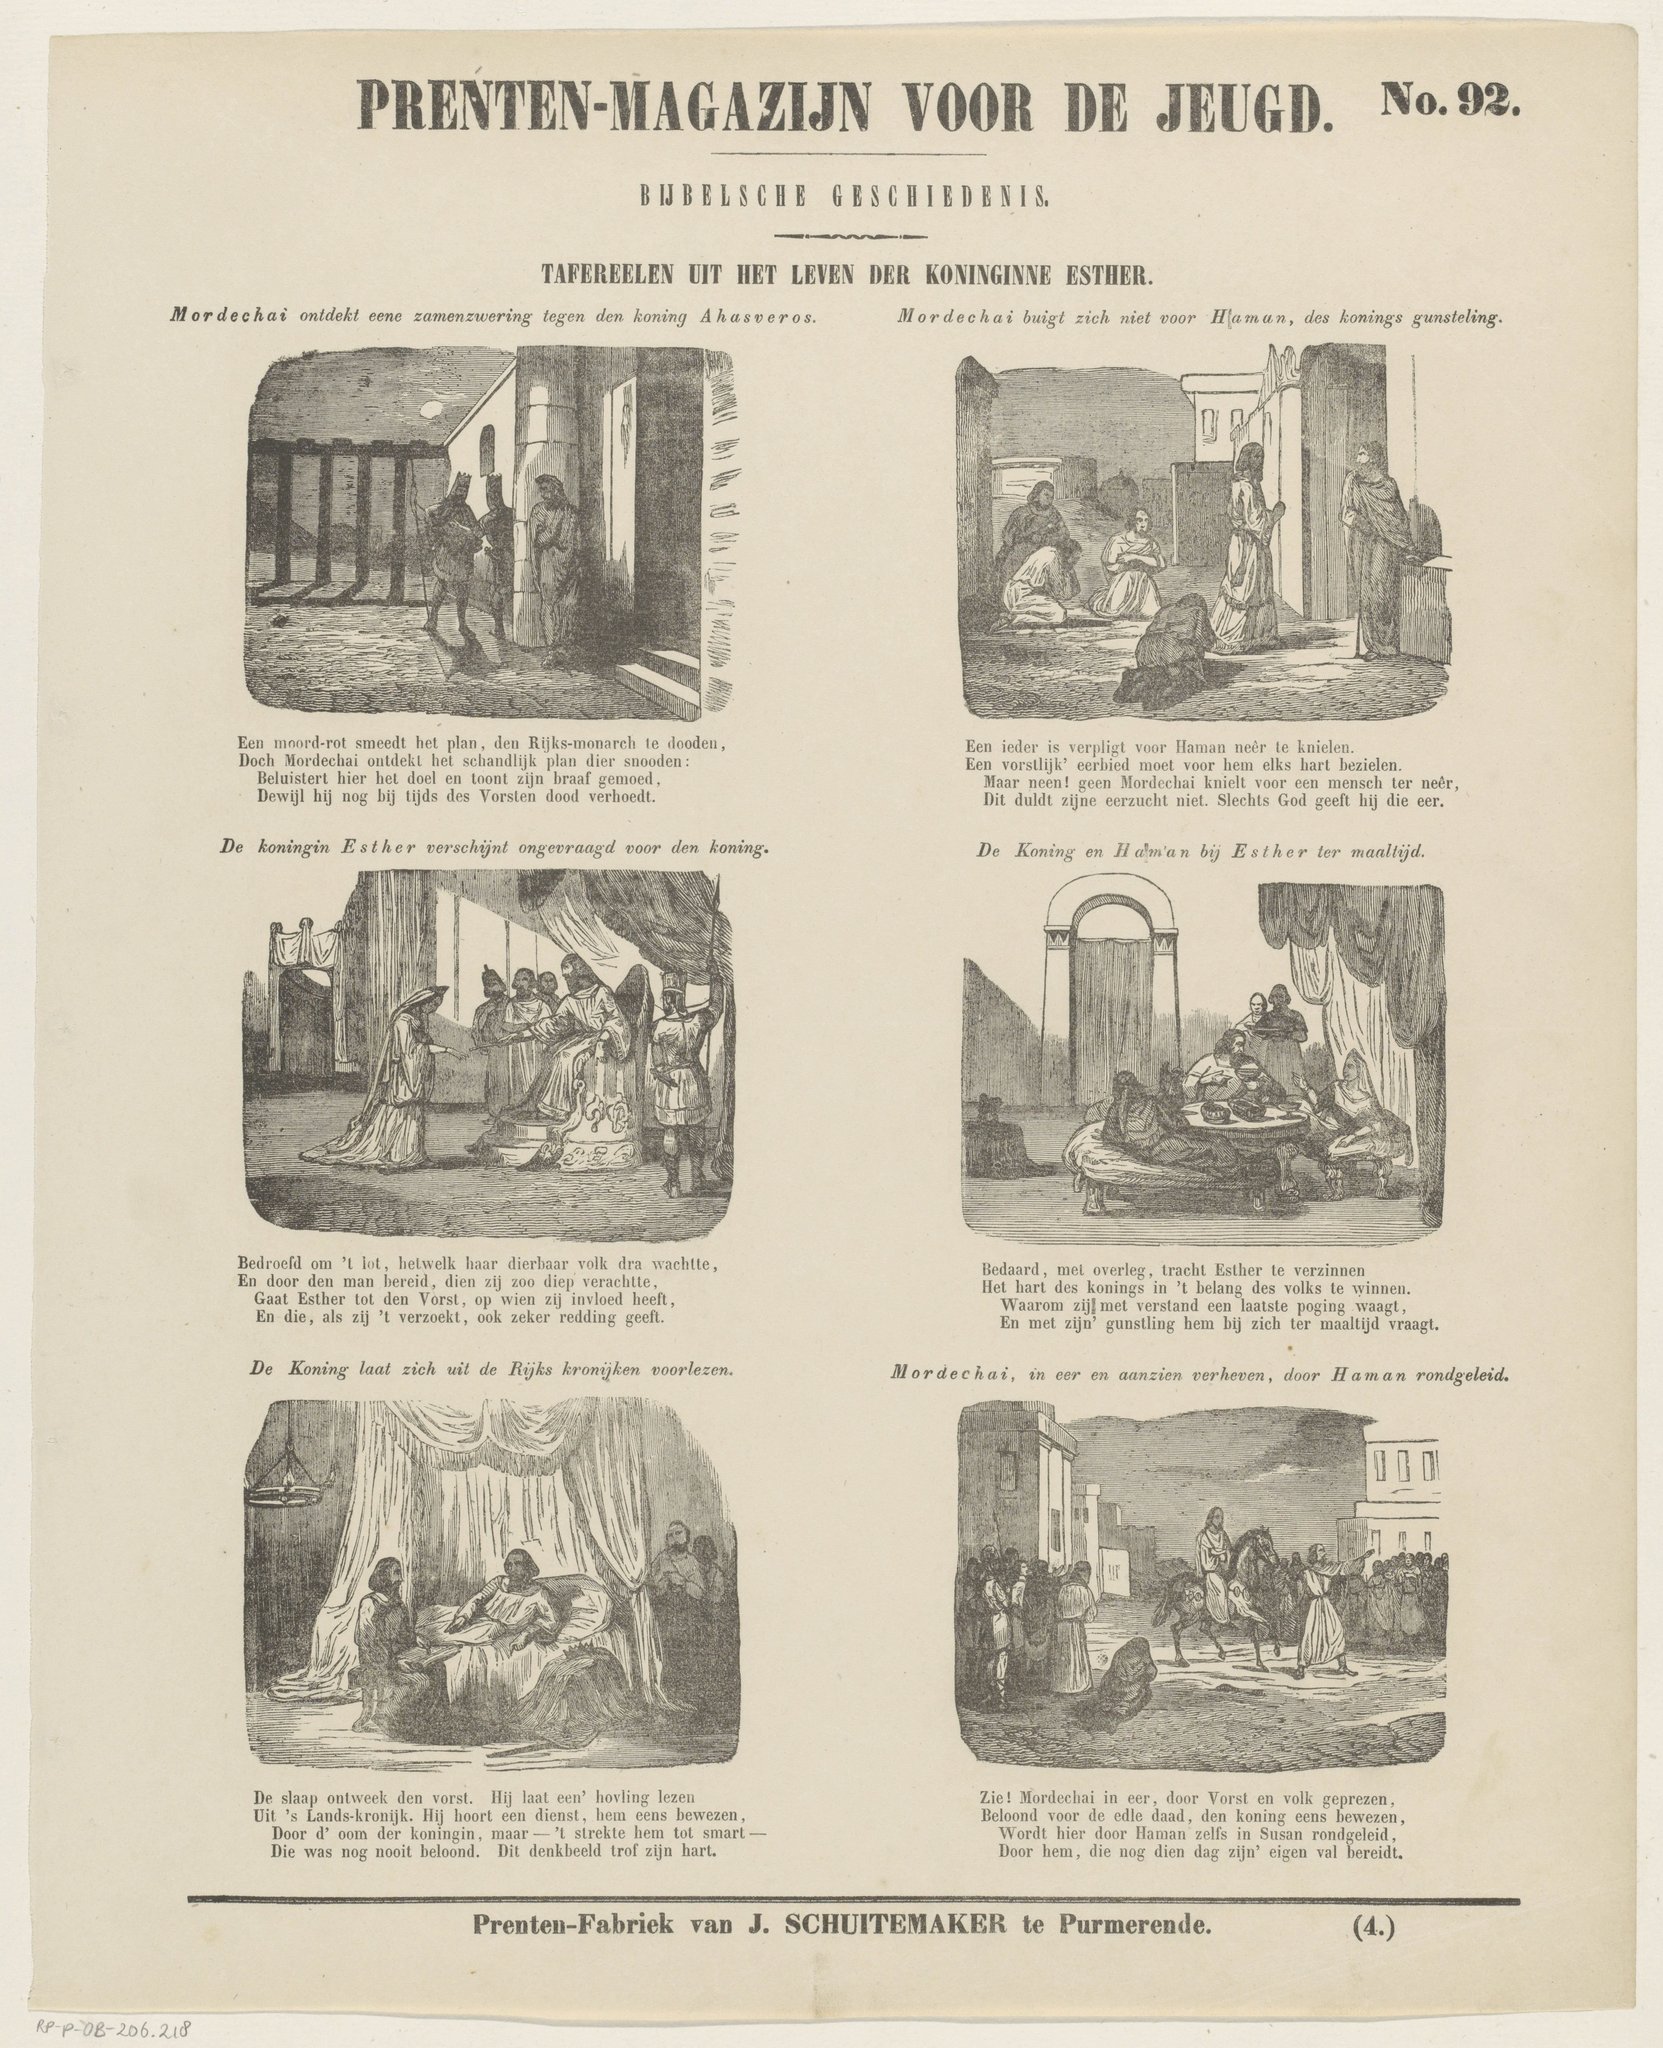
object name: print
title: Bijbelsche geschiedenis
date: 1850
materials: paper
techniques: letterpress printing, engraving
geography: netherlands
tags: the story of esther, old testament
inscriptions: collector's mark: Lugt 2760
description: Na voltooiing van de acht jaargangen van de reeks 'Prenten-magazijn voor de jeugd' in 1850 heeft Jan Schuitemaker al deze prenten heruitgegeven en omgenummerd als nr. 1 t/m 192. De oorspronkelijke jaargang wordt telkens nog vermeld rechtsonder op de prent. Binnen de jaargangen zijn prenten van hetzelfde thema in clusters van vier achter elkaar gezet.